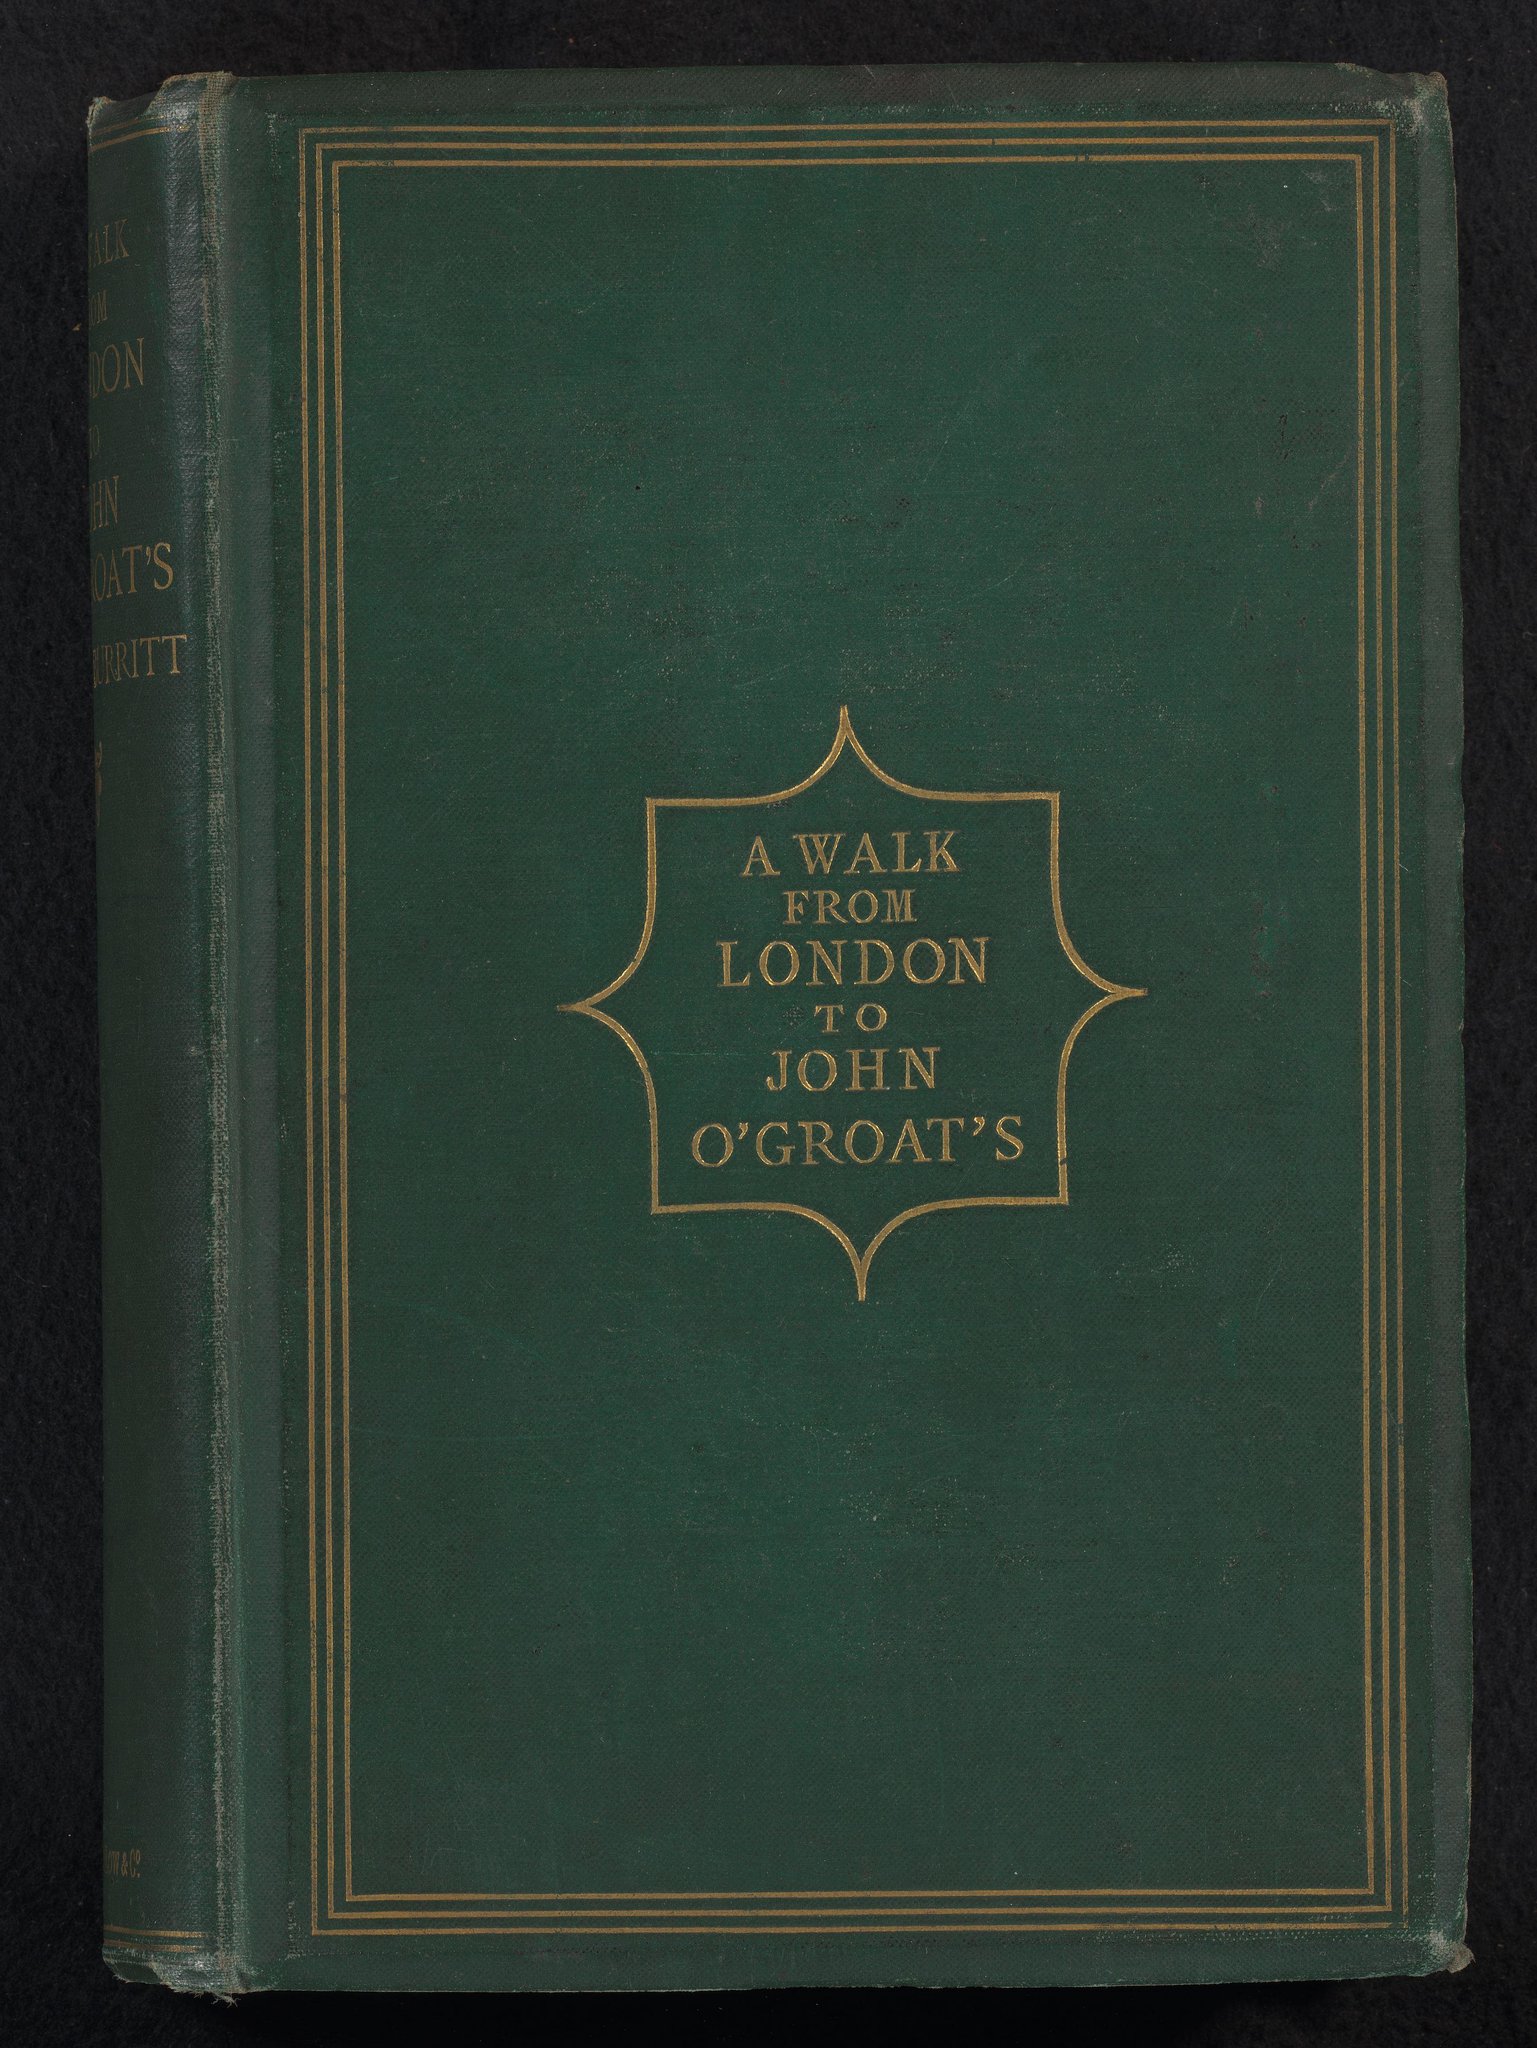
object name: book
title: A walk from London to John O'Groat's, with notes by the way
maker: elihu burritt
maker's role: diplomaat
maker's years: 1810-1879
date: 1864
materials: cardboard, paper, linen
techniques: albumen print, letterpress printing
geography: london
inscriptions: inscription: ‘EDMONDS,/ Bookseller &c/ 5, Commercial Place/ BRIXTON’, inscription: ‘BOUND BY/ BURN/ 37 & 38/ KIRBY ST.’, inscription: ‘Edwin Crosley/ March 14th 1865’, inscription: ‘M/R/ Searce/ 5 Photos/ ad at Ef/ ECRm Anatheus &ta/ E G [...]’